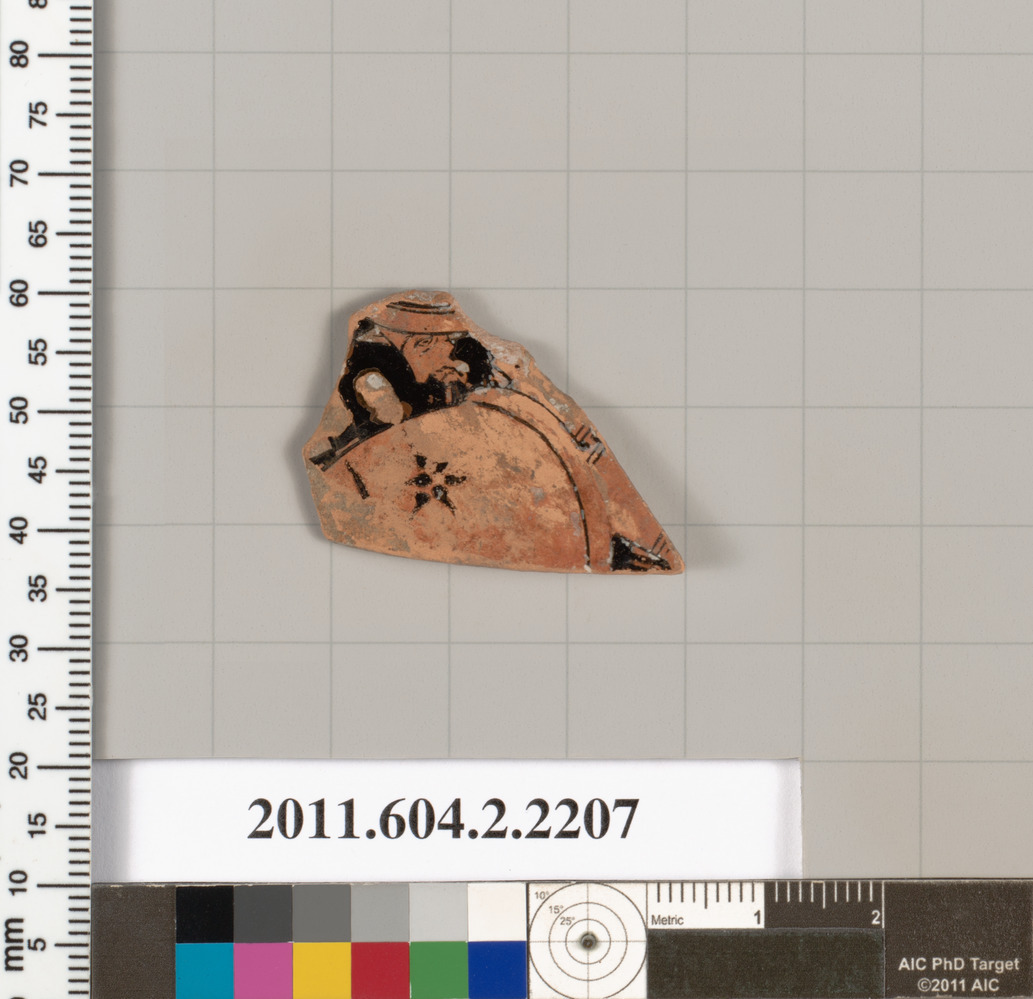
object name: pot fragment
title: Terracotta fragment of a pot; unglazed on the inside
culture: greek, attic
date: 475-451 BCE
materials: terracotta